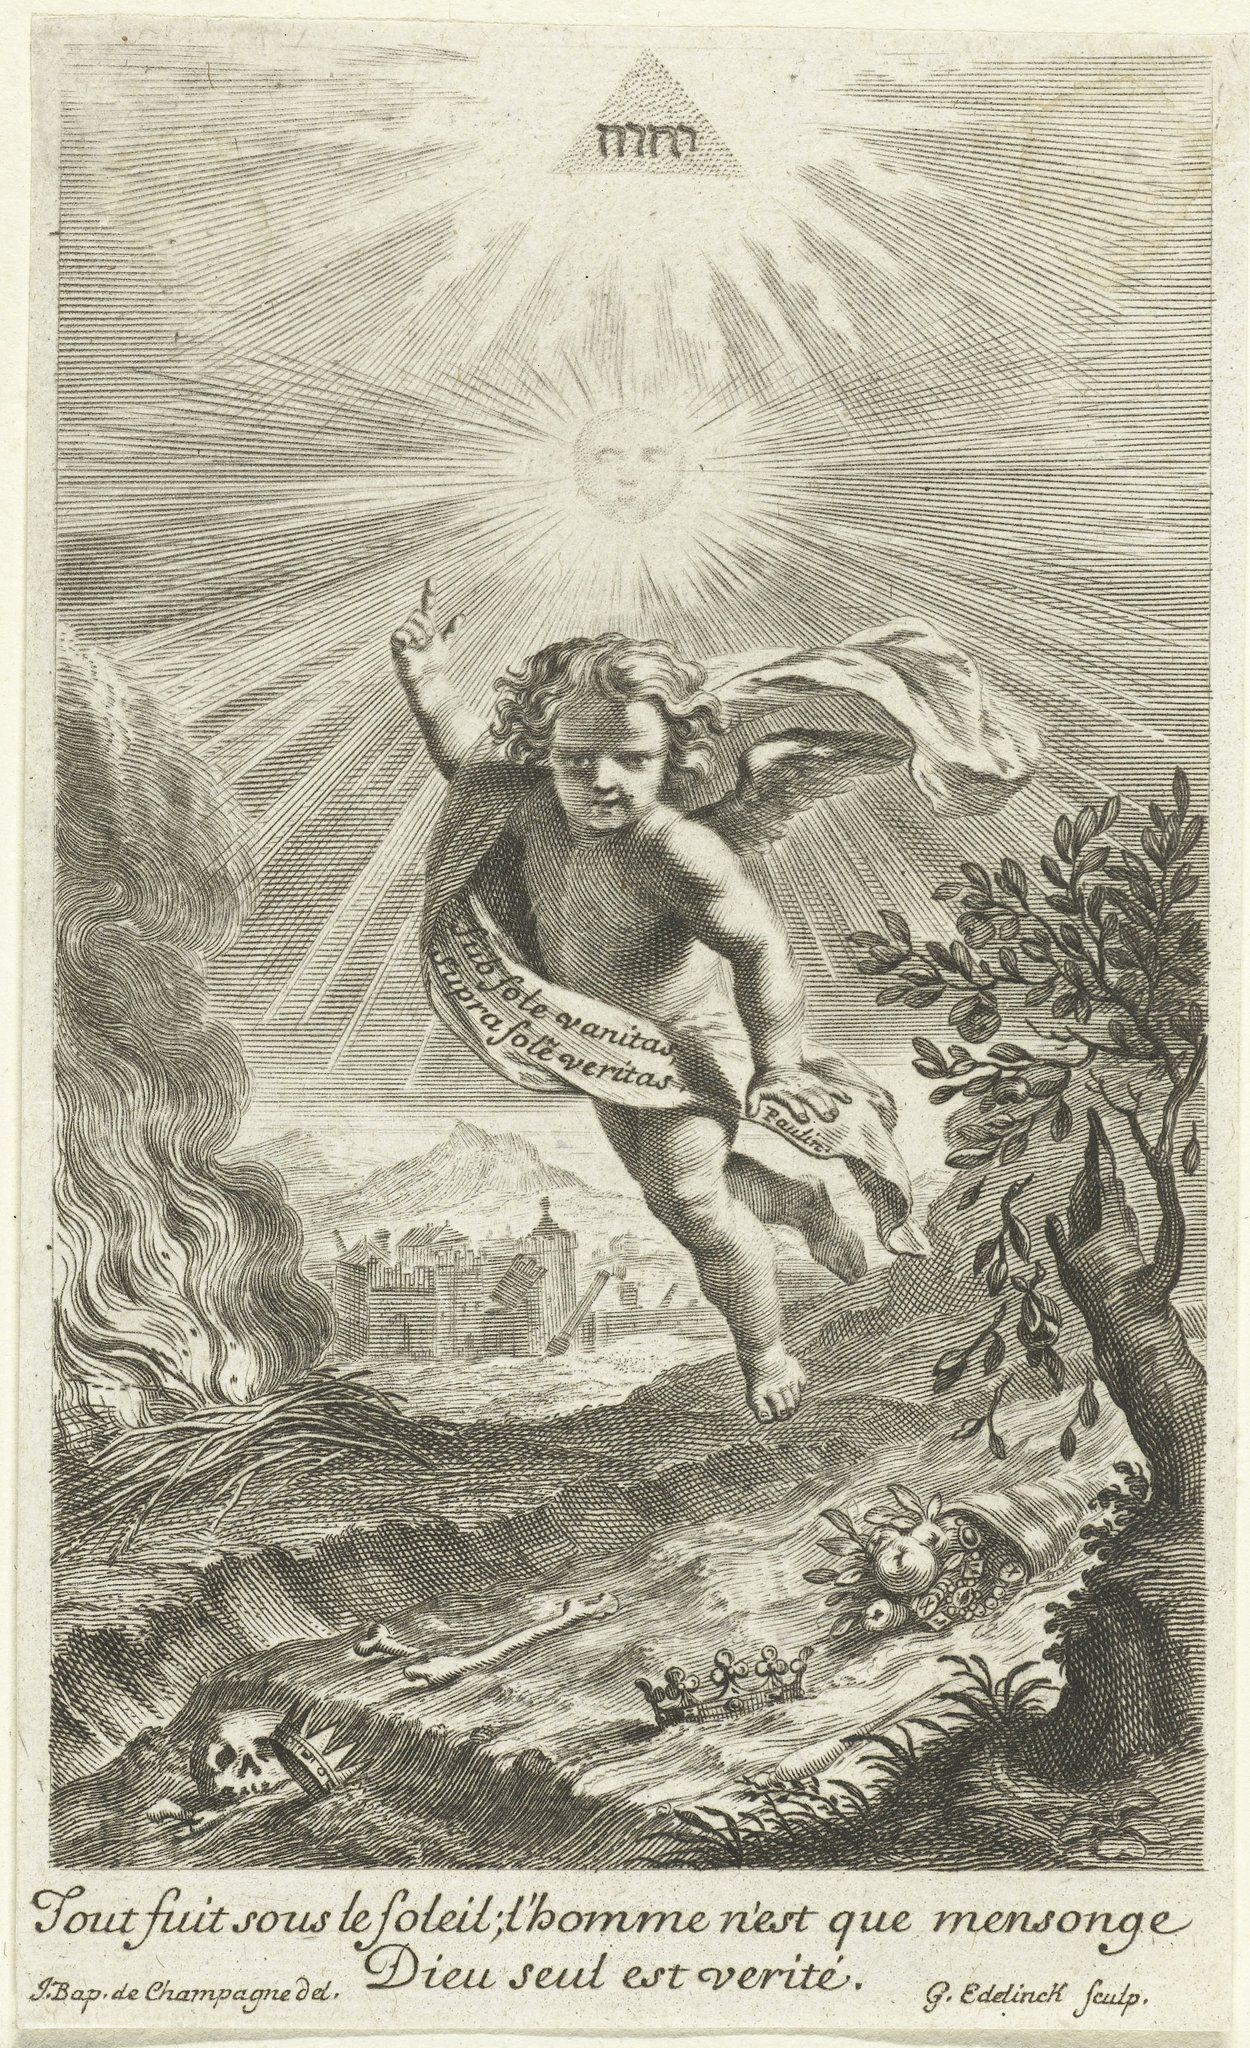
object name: print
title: Vliegende engel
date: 1666-1707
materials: paper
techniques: engraving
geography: paris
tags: angle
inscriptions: collector's mark: Lugt 240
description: Een engel zweeft boven een rivier waarin de hoorn des overvloeds, kronen en botten wegdrijven, hij wijst omhoog naar de zon en de glorie van God erboven. Op de achtergrond een brand en een vervallen stad. Het onderschrift wijst erop dat alleen God waarlijk is.